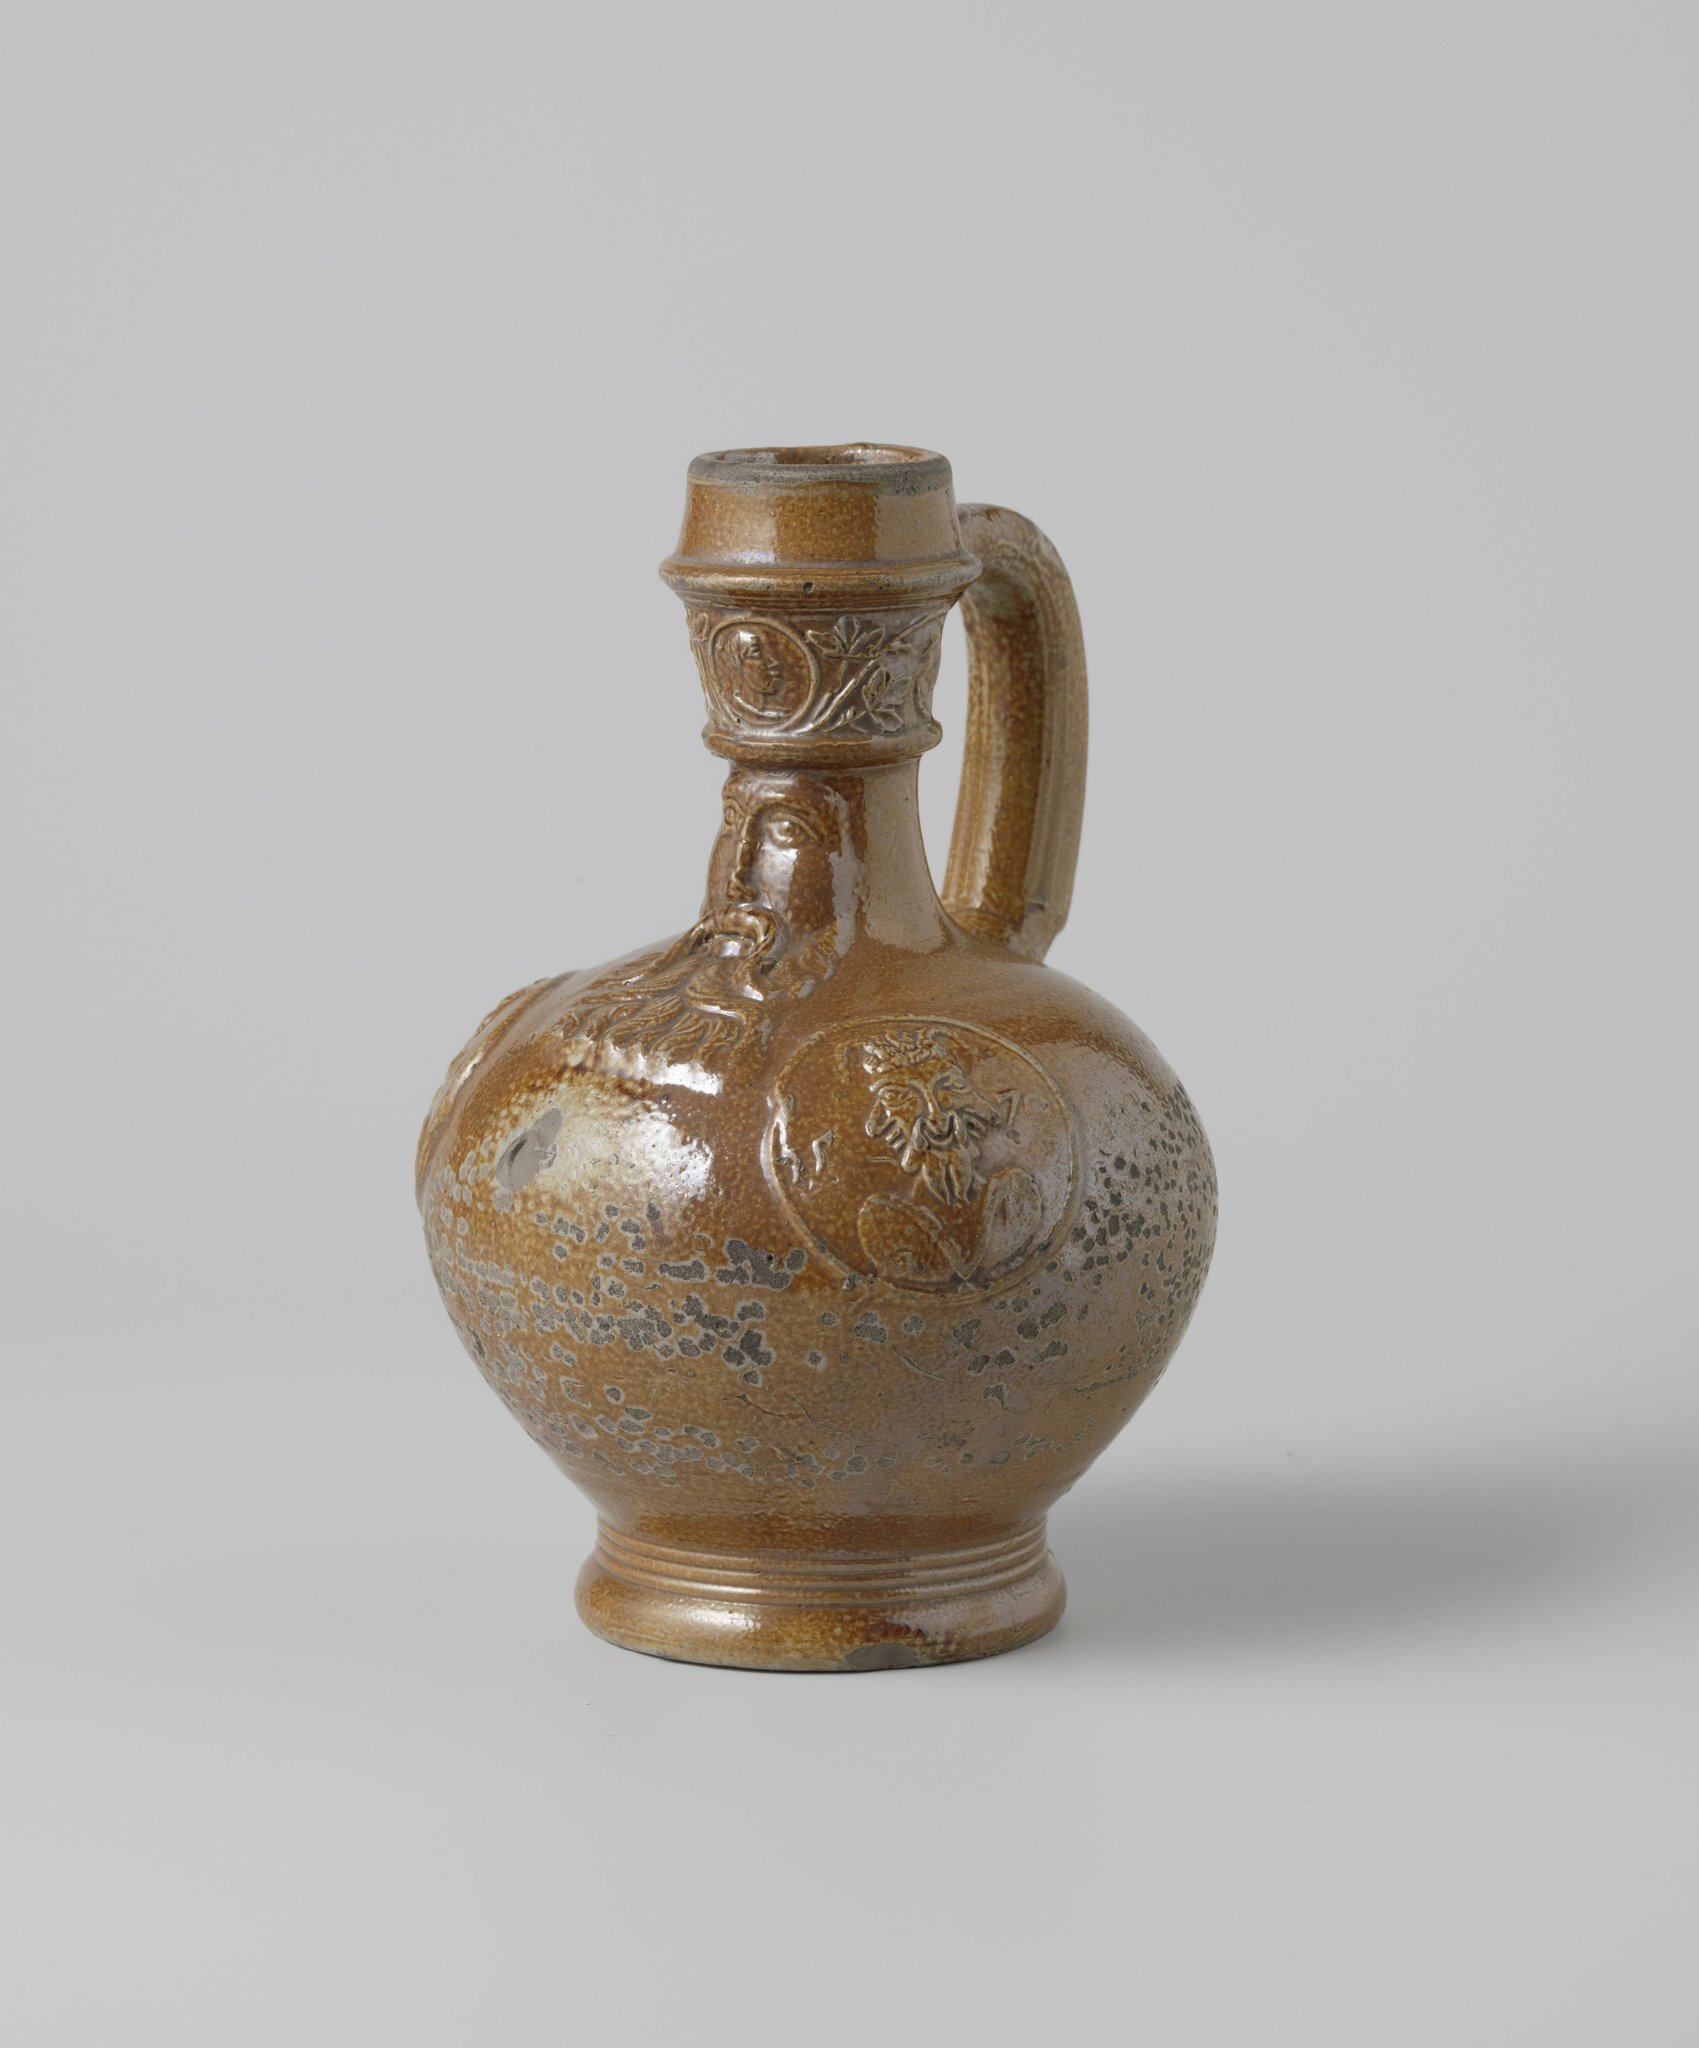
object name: bellarmine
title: Jug 'Bartmann jug' with satyrs, portrait and flower sprays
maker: Anonymous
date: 1570-1580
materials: engobe, glaze, stoneware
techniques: firing, forming, relief, turning, vitrification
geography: raeren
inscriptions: date: ‘1570’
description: Kruik (baardmankruik) van steengoed op hoge voet met een bolvormig lichaam en smalle nek. Het C-vormige oor is bevestigd aan de nek en de schouder. Profielen op de nek en voet. Bedekt met een bruine engobe. Op de nek in reliëf een gedrukte en opgelegde baardman, de baard doorlopend op de buik. Aan weerszijden van de baard een medaillon met een driekoppige sater en de datum '1570'. Op de nek een band met een portret en profil omgeven door bloemtakken. Raeren.